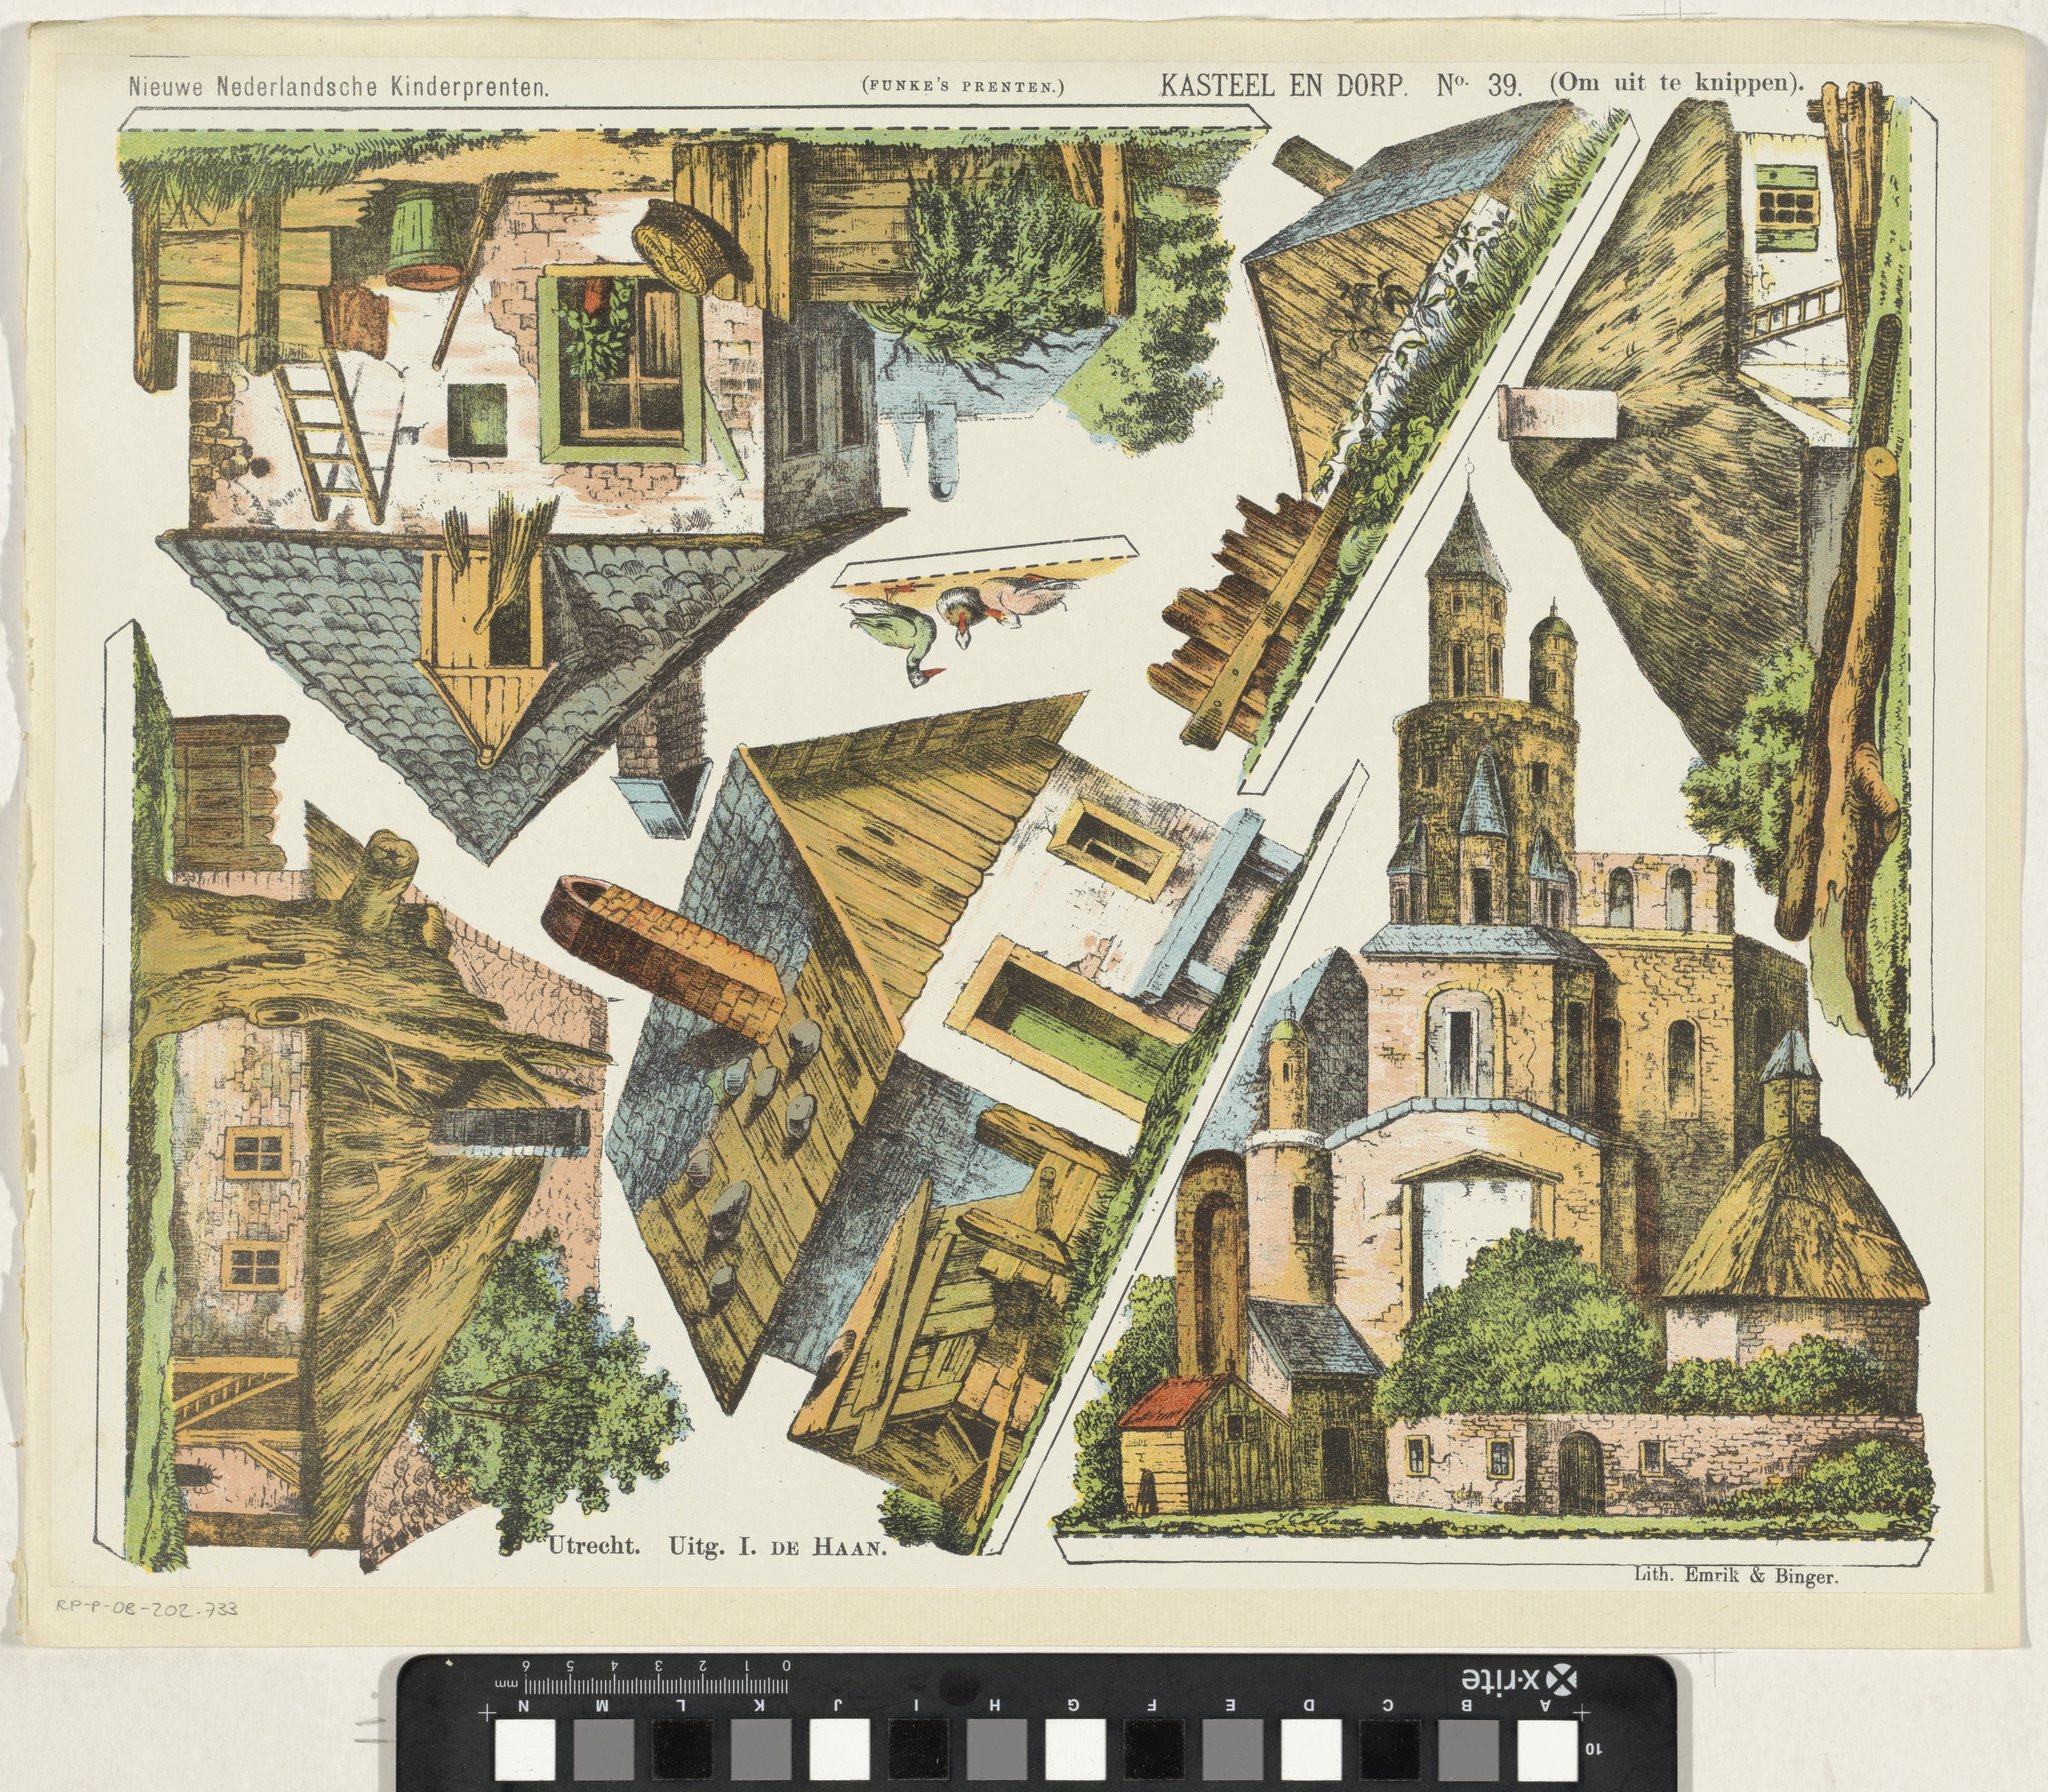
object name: print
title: Kasteel en dorp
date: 1875-1903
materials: paper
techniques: lithograph, letterpress printing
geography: utrecht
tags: water-birds: goose, castle, farm (building)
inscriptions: collector's mark: Lugt 2760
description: Blad met 7 voorstellingen van een kasteel, boerderijen en ganzen om uit te knippen. Genummerd rechtsboven: No. 39.